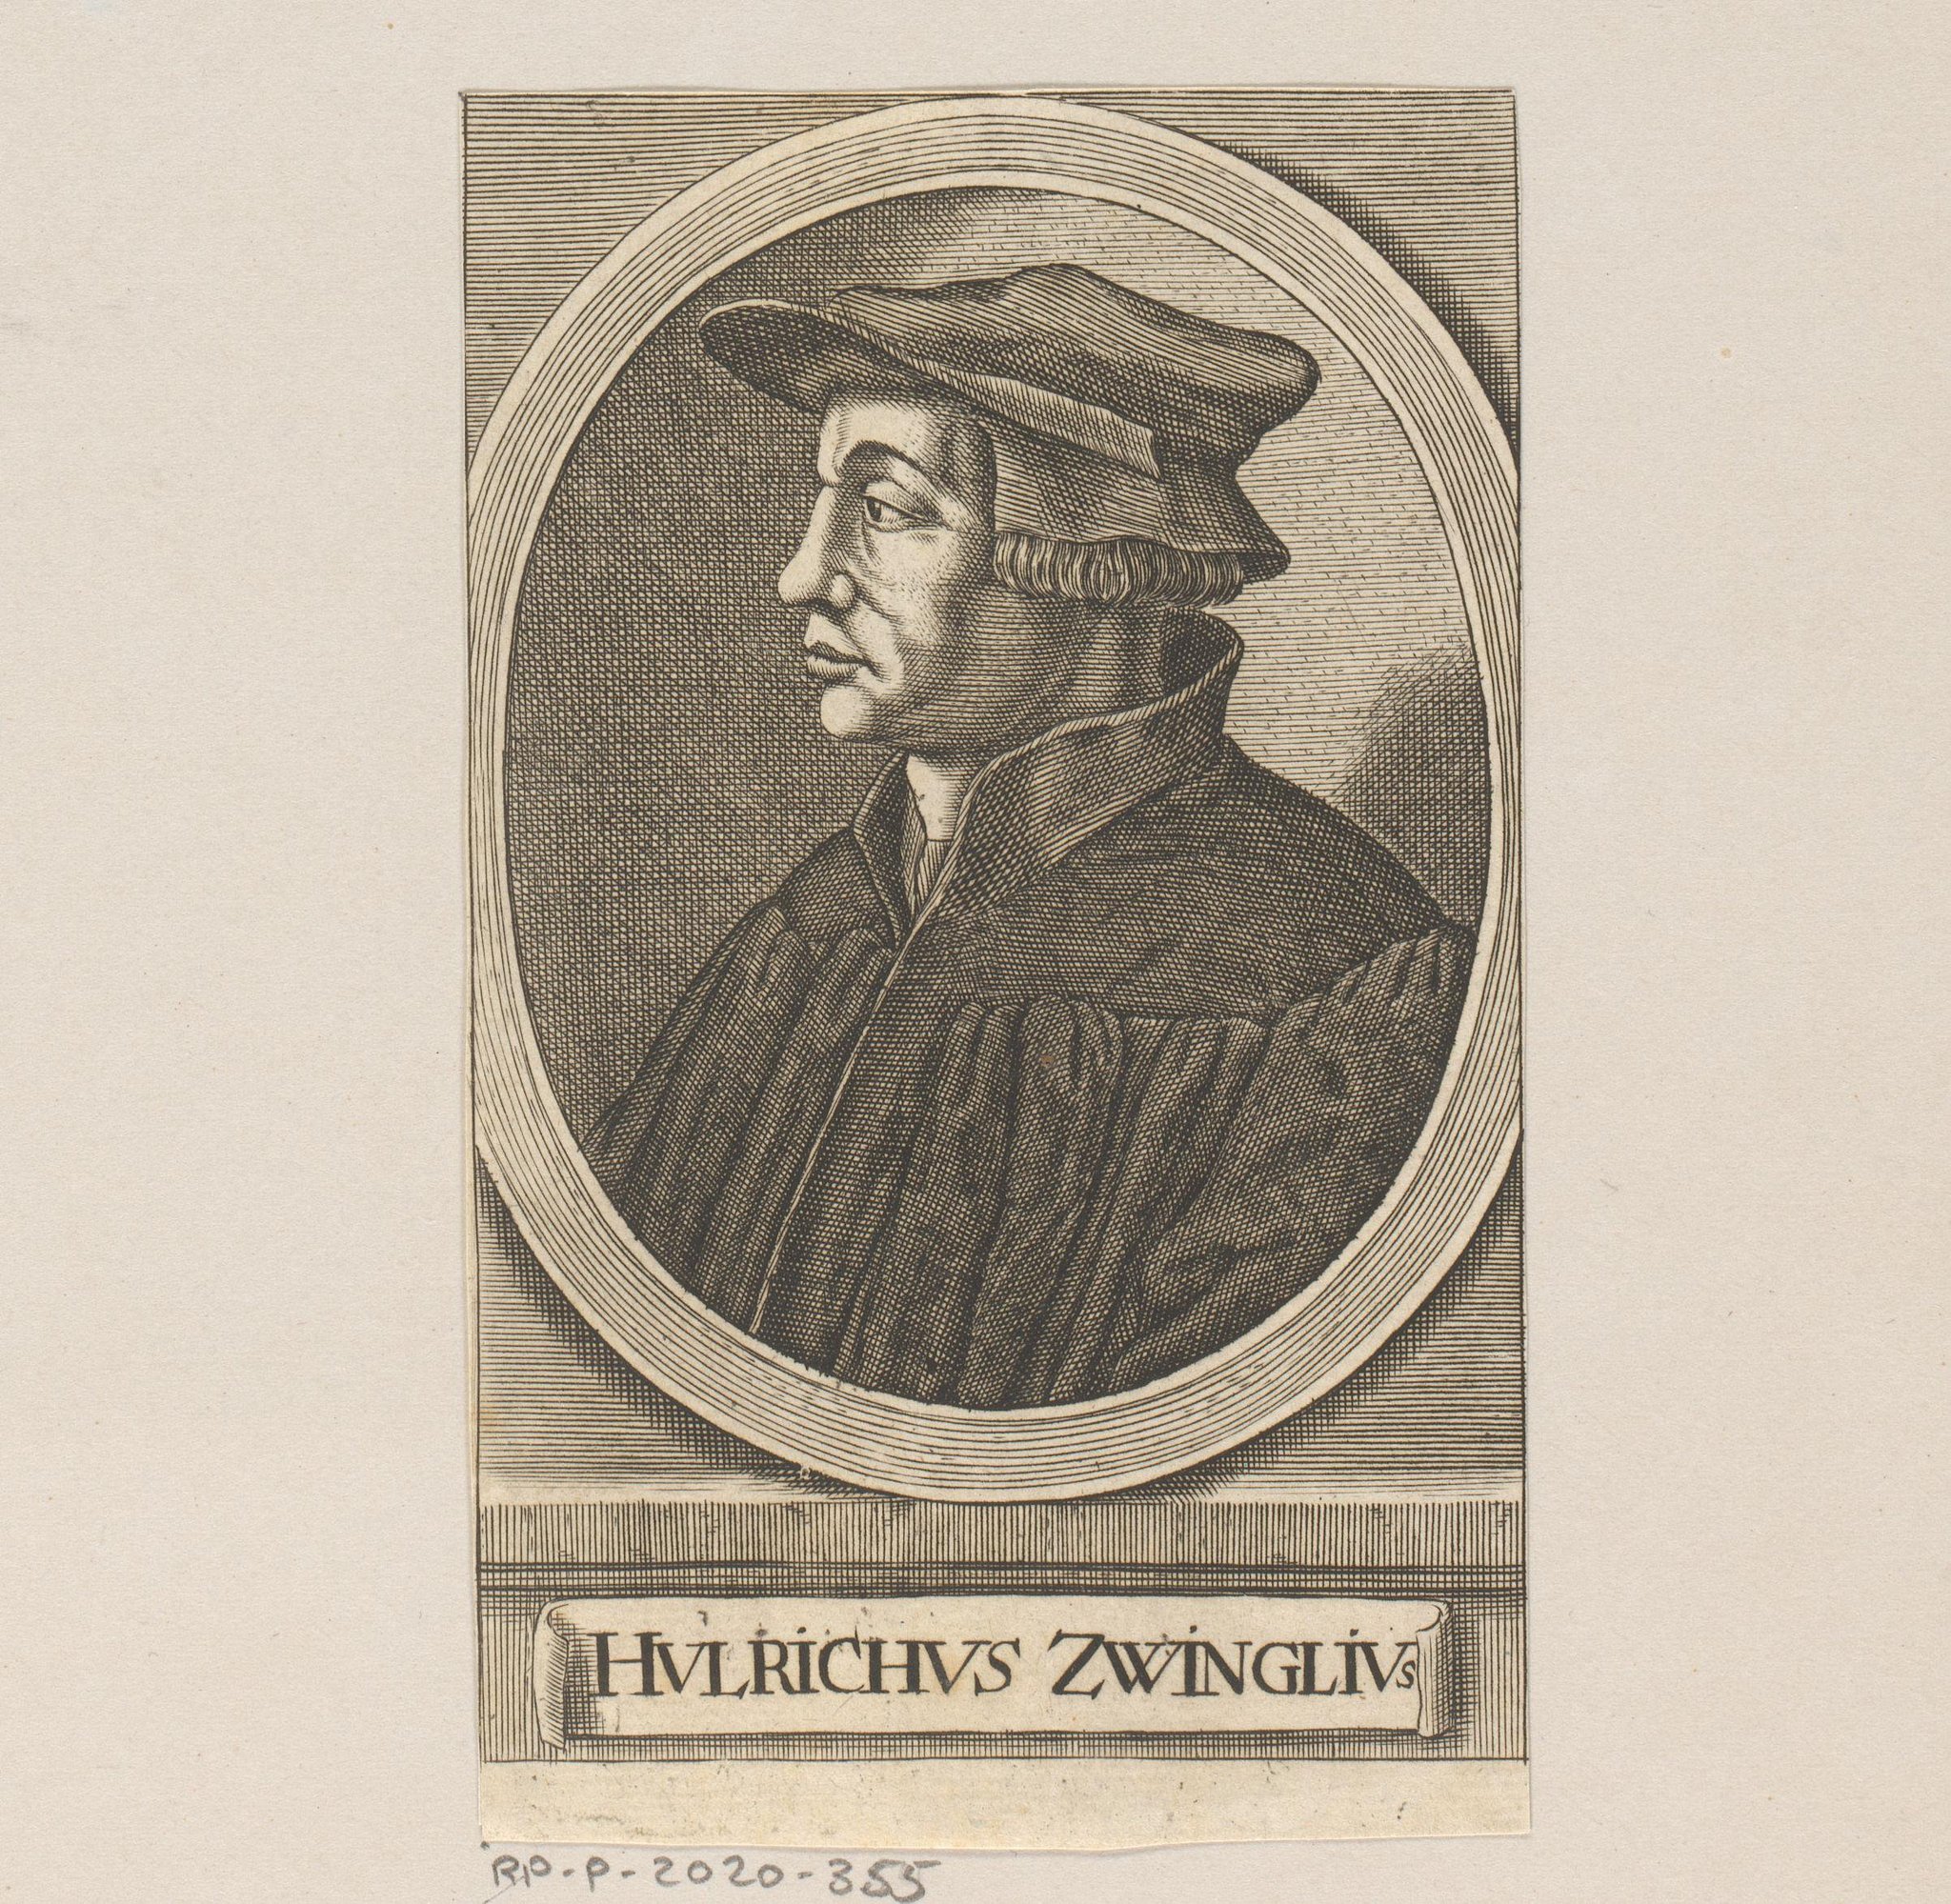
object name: print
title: Portret van Ulrich Zwingli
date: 1662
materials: paper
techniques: engraving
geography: amsterdam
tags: theologian, historical persons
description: Prent uit: Corput, Abraham van den. Het leven, ende dood, van den seer beroemden D. Philips Melanchton. Amsterdam: Abraham Wolfgang, 1662. Prent ook gebruikt in de 1728-editie van dit werk.